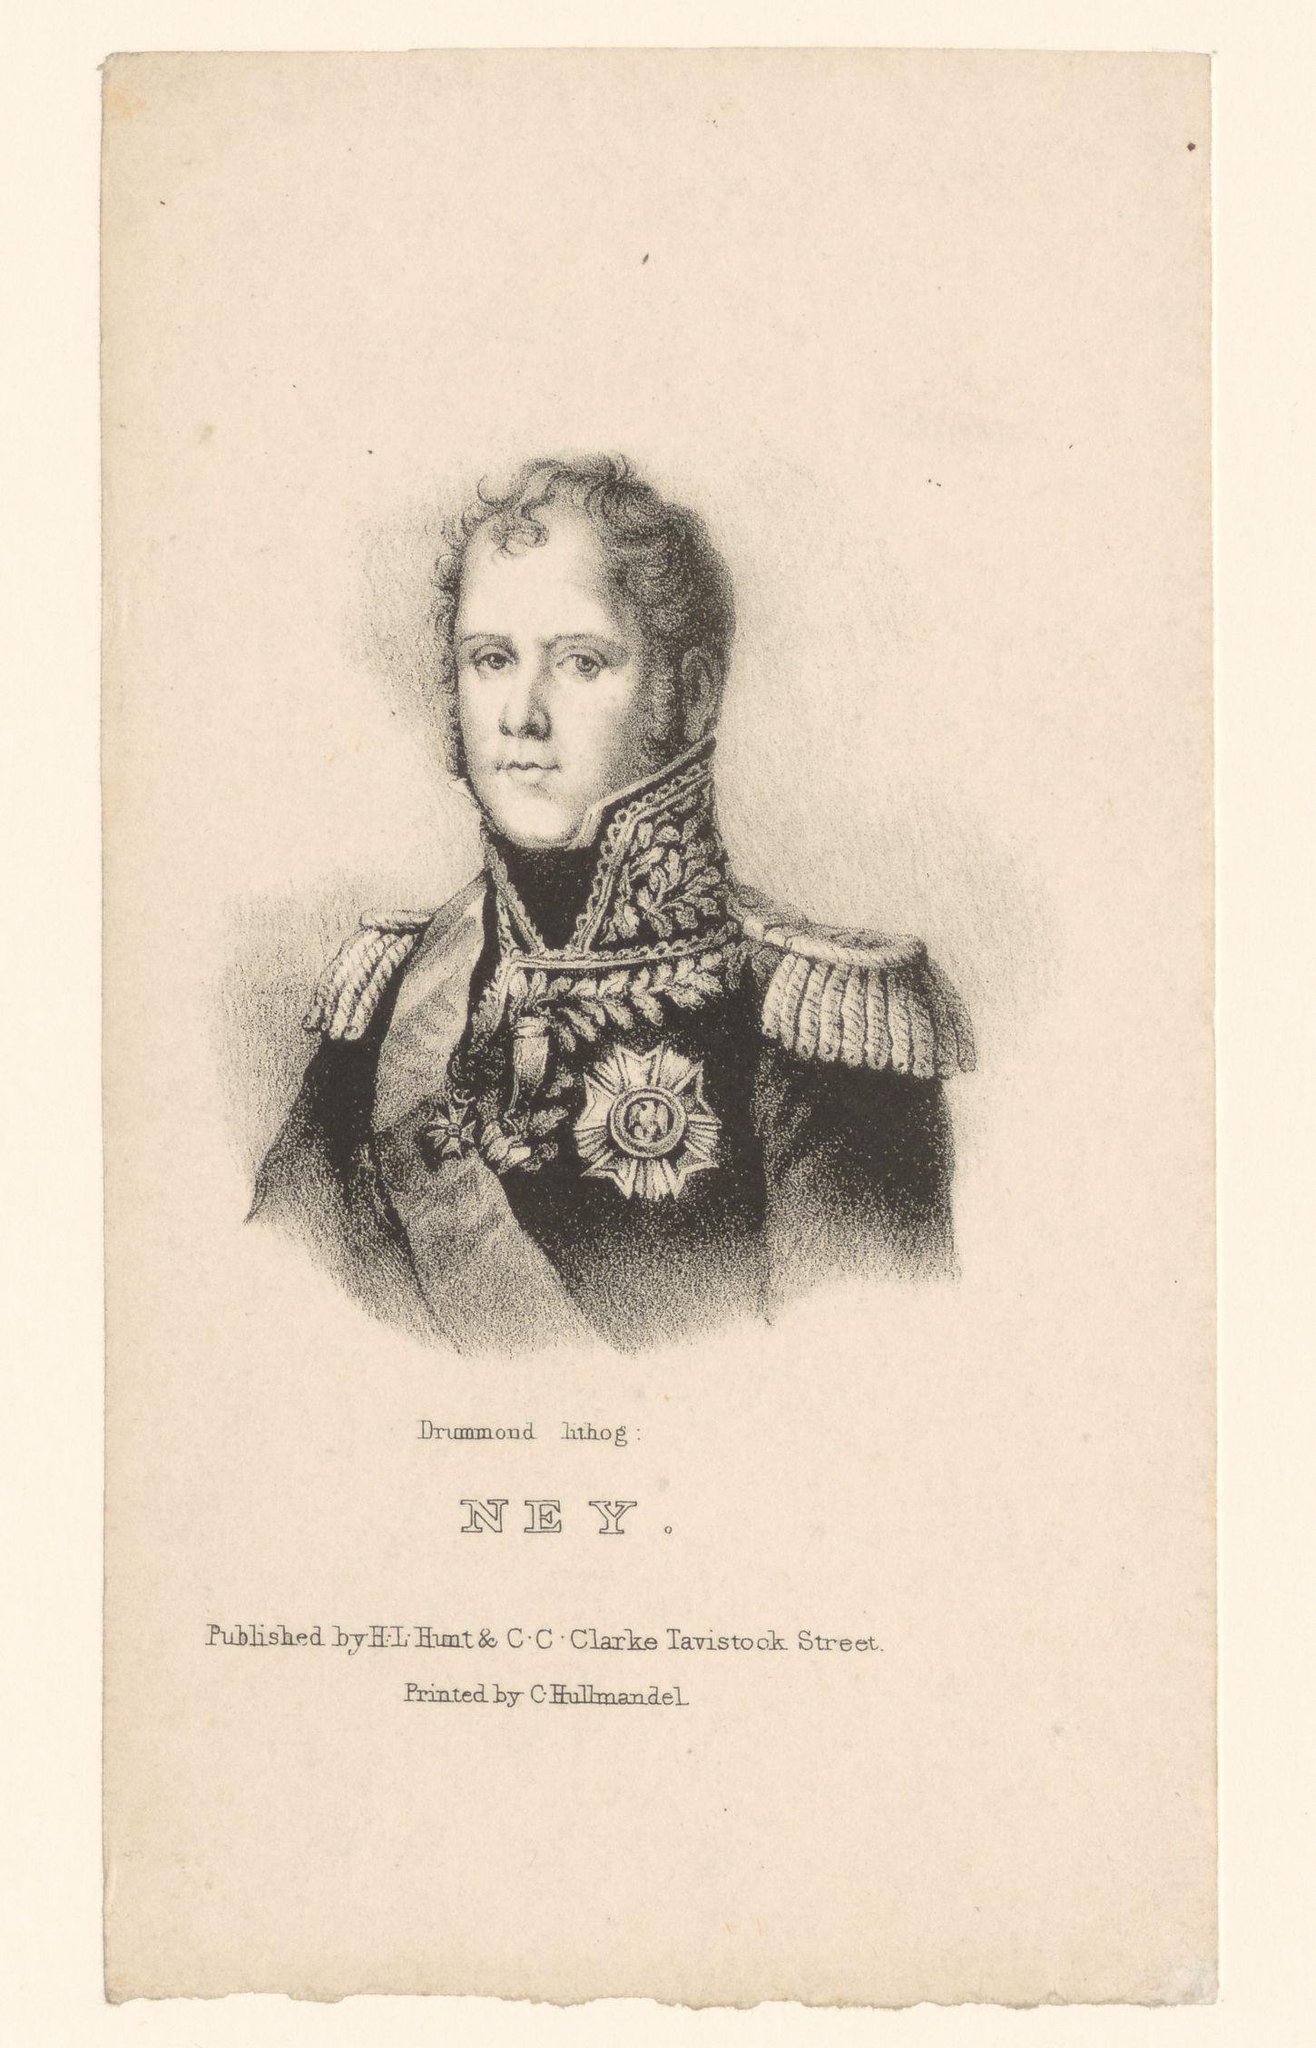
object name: print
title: Ney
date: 1826-1849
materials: paper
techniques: lithograph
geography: london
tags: paris, adult man, historical persons, (military) uniforms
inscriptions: collector's mark: Lugt 2228